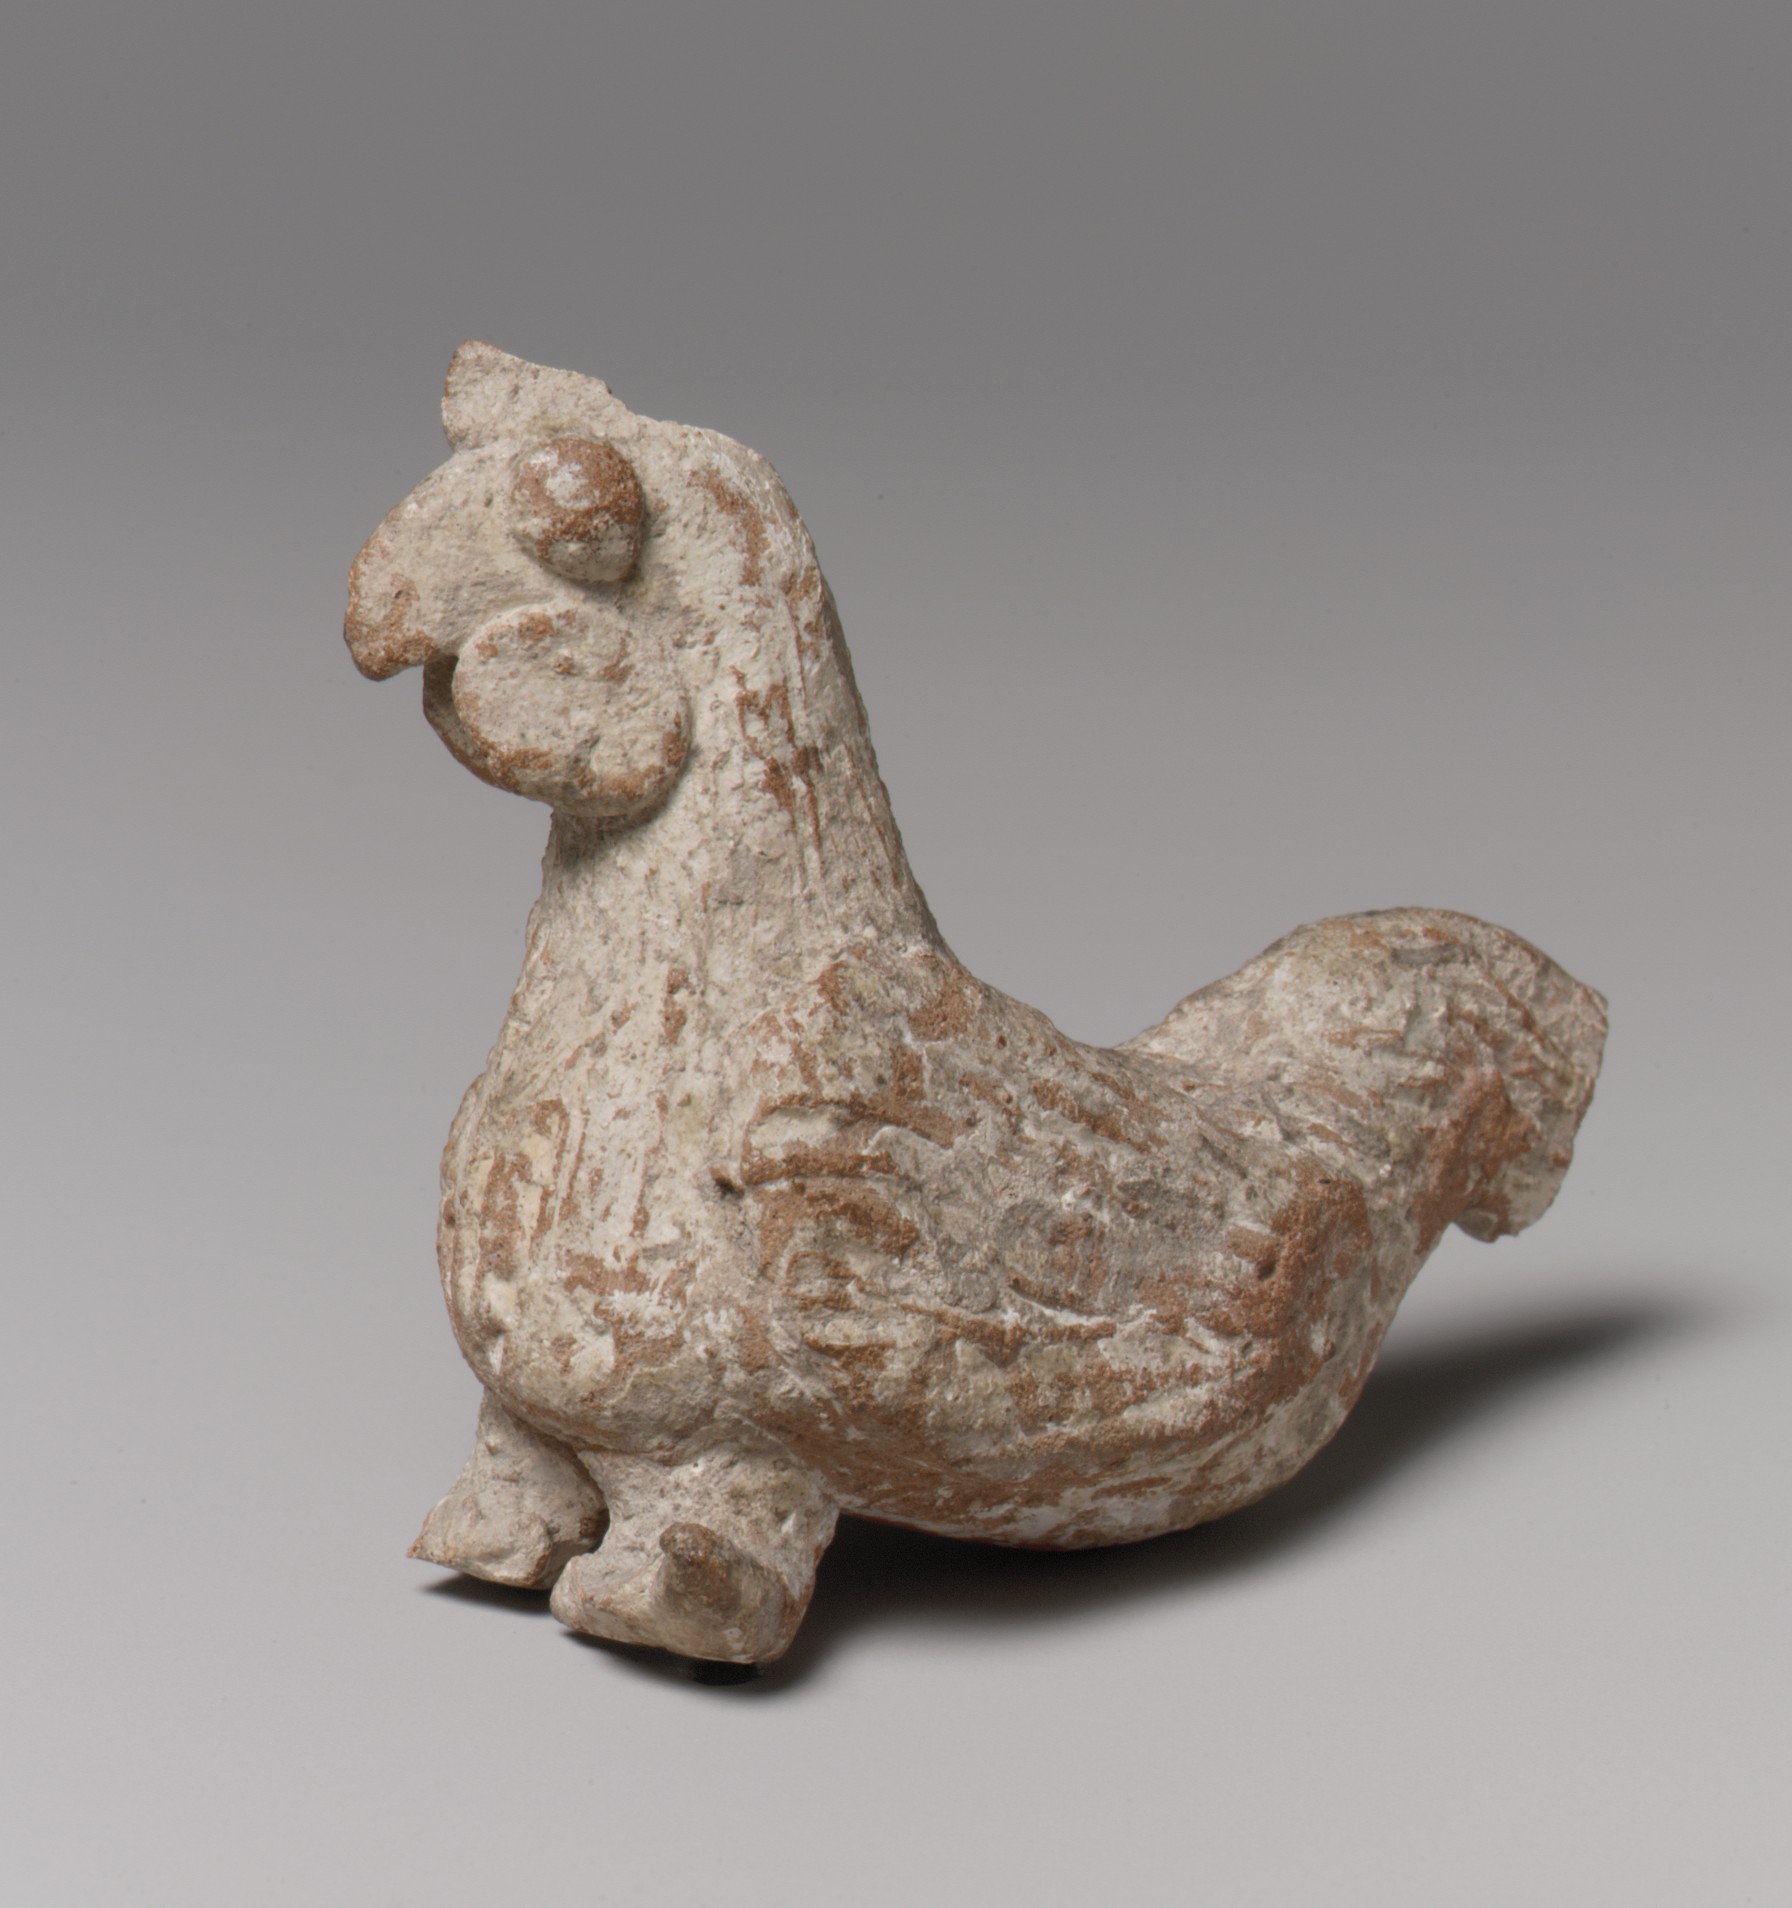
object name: statuette of a cock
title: Terracotta statuette of a rooster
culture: greek, cypriot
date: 200-1 BCE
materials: terracotta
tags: roosters